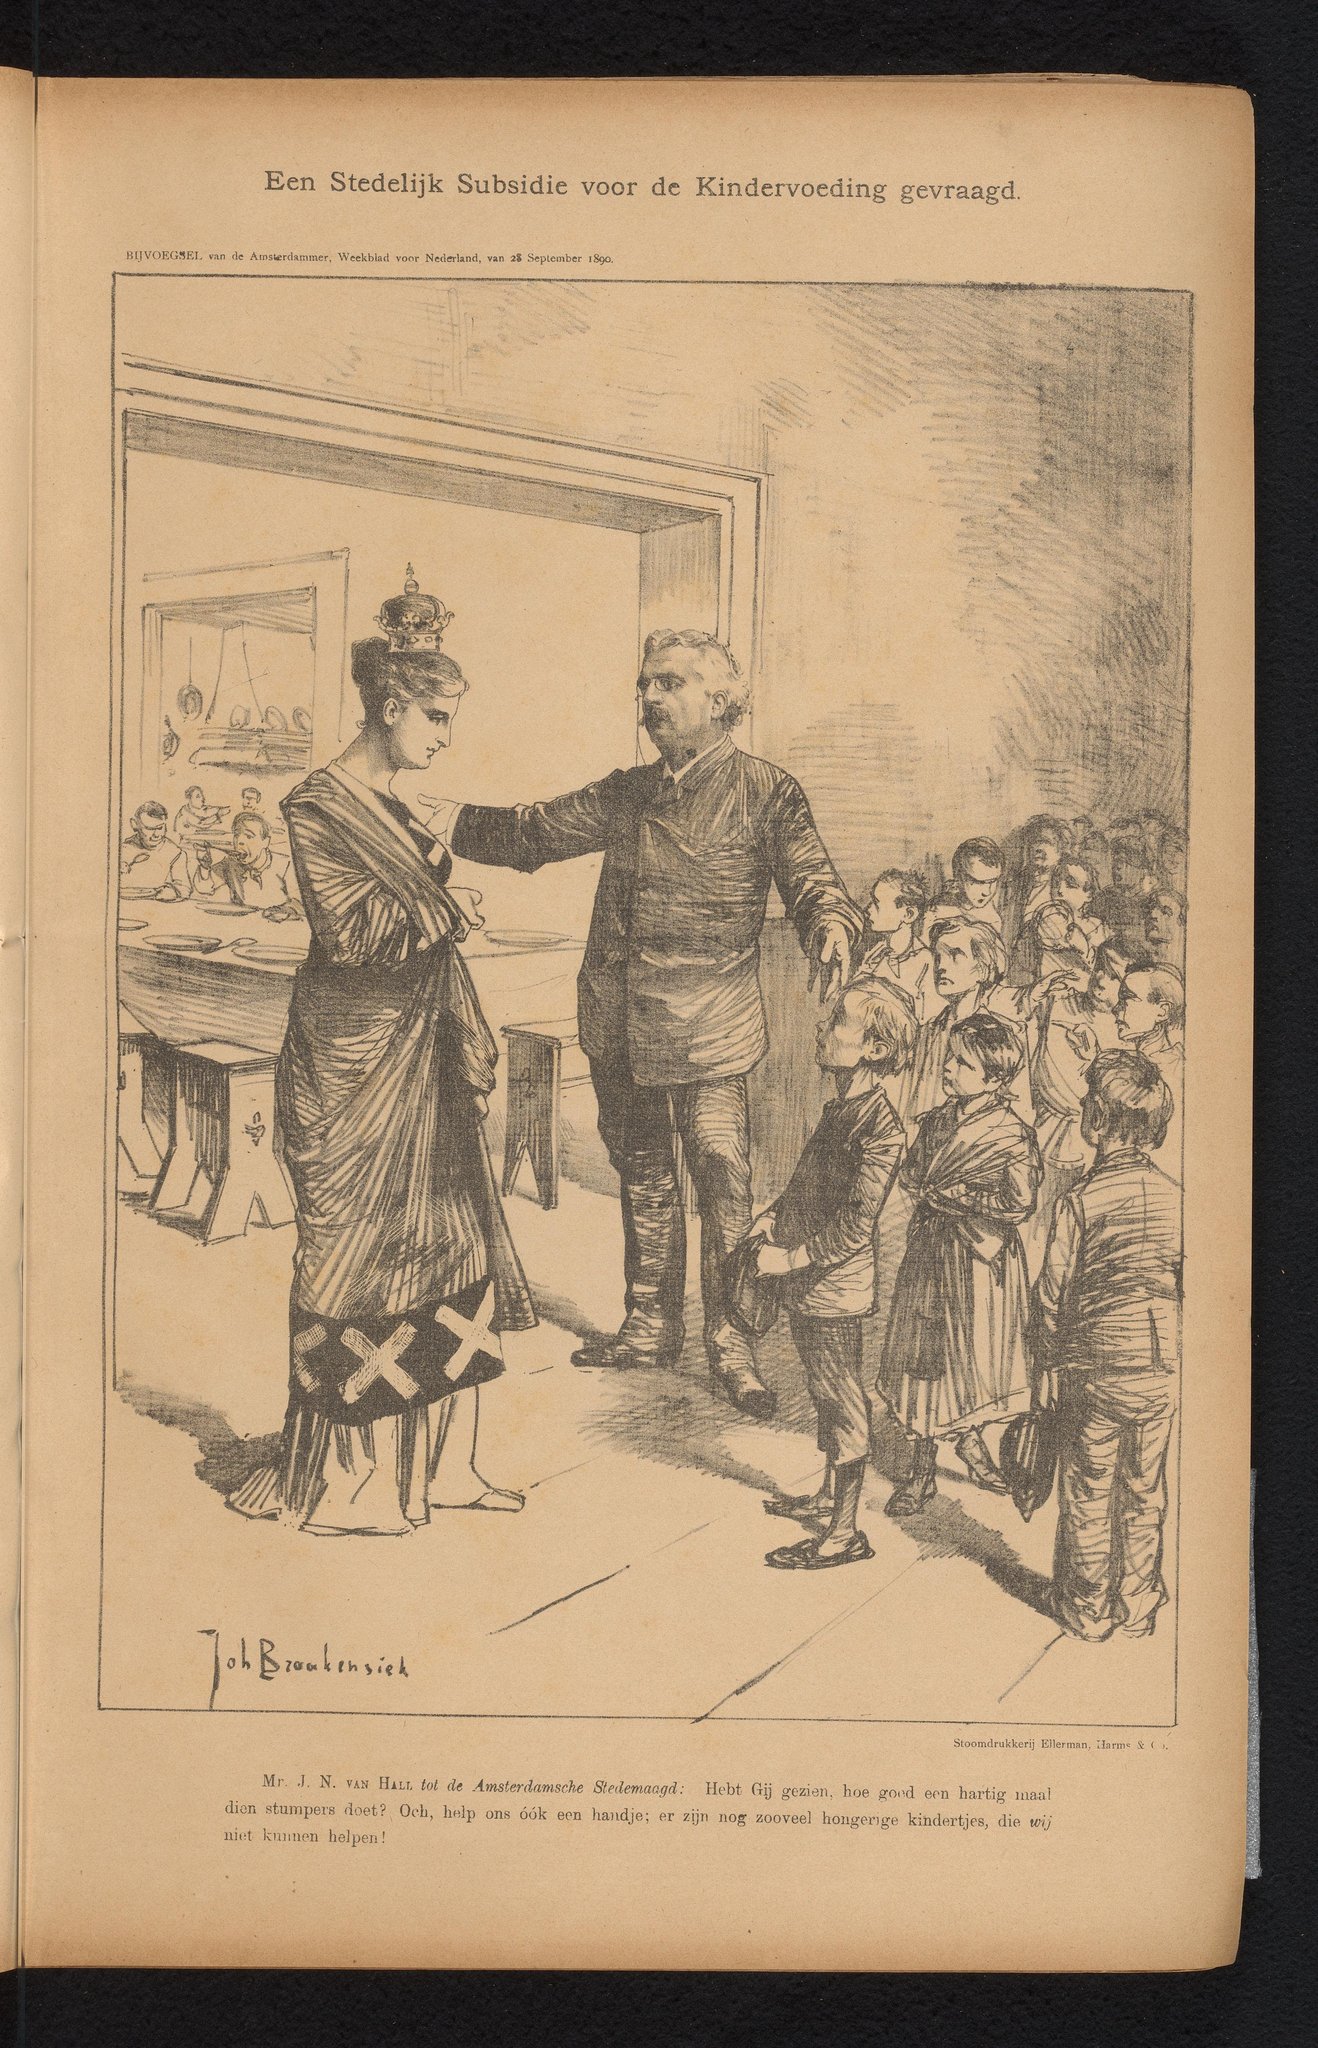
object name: print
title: Een Stedelijk Subsidie voor de Kindervoeding gevraagd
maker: johan braakensiek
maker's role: draughtsman, print maker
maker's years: 1858-1940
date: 1890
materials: paper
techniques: lithograph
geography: amsterdam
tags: amsterdam, politician, jacob nicolaas van hall, hunger, personification of a city, town-patron(ess), child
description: Jacob Nicolaas van Hall doet een beroep op de stadsmaagd van Amsterdam voor hulp bij het voeden van hongerige stadskinderen.